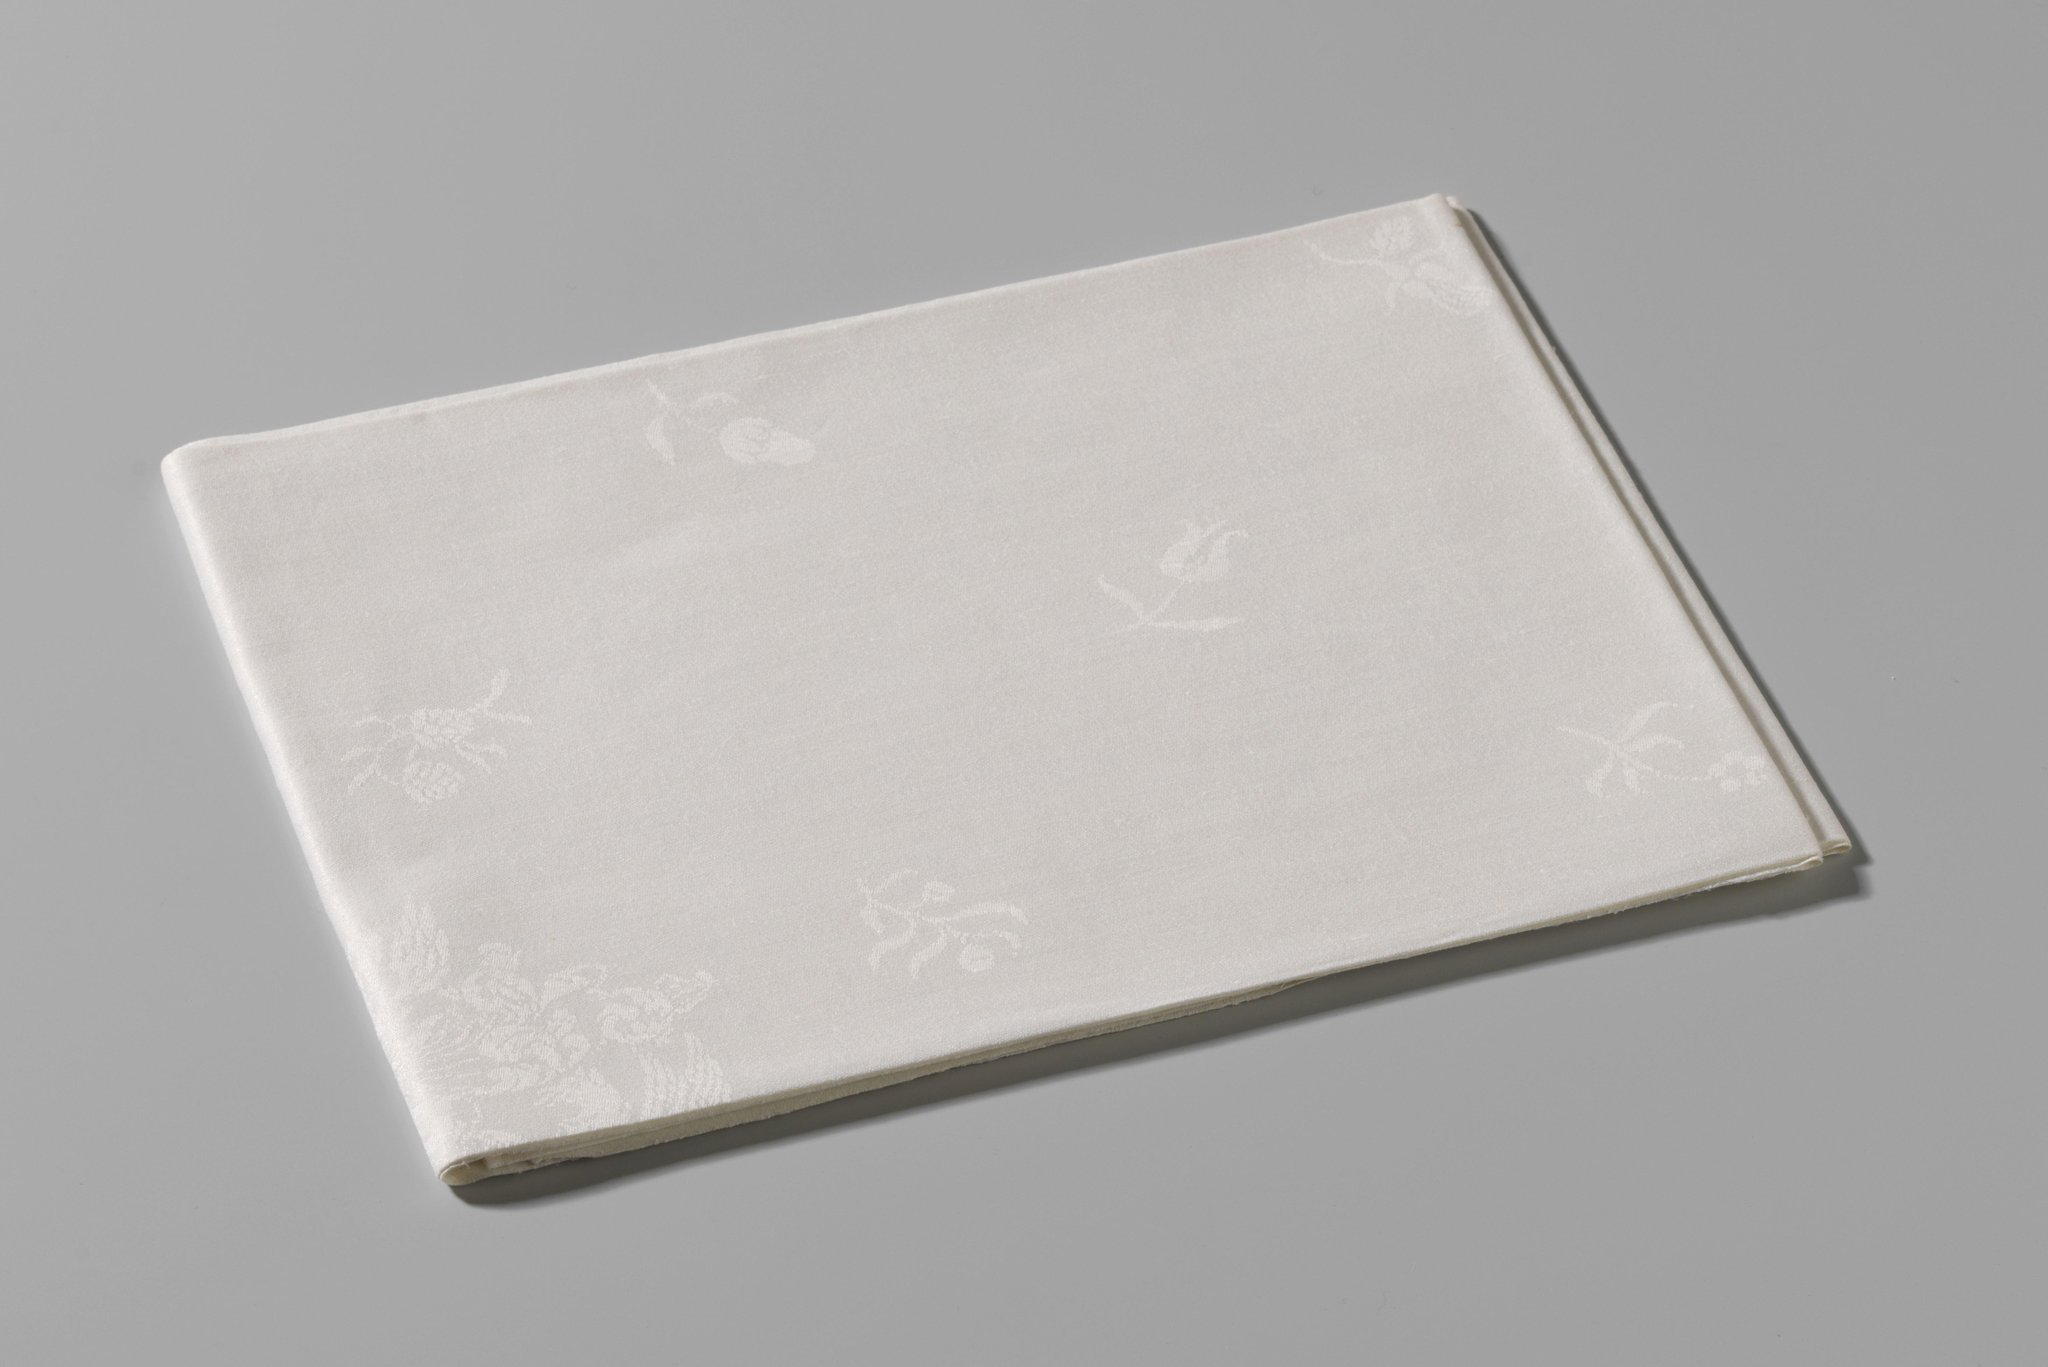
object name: napkin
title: Servet met het familiewapen Van der Dussen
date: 1870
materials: linen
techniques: damask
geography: boxtel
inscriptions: mark: ‘bladrank 19’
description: Servet van linnendamast met het familiewapen Van der Dussen. Middenveld: wapenschild temidden van gestrooide bloemknoppen. Randen: drie drievoudige banden, de middelste met een bladrank, de andere glad en omslingerd met een spiraaltak.